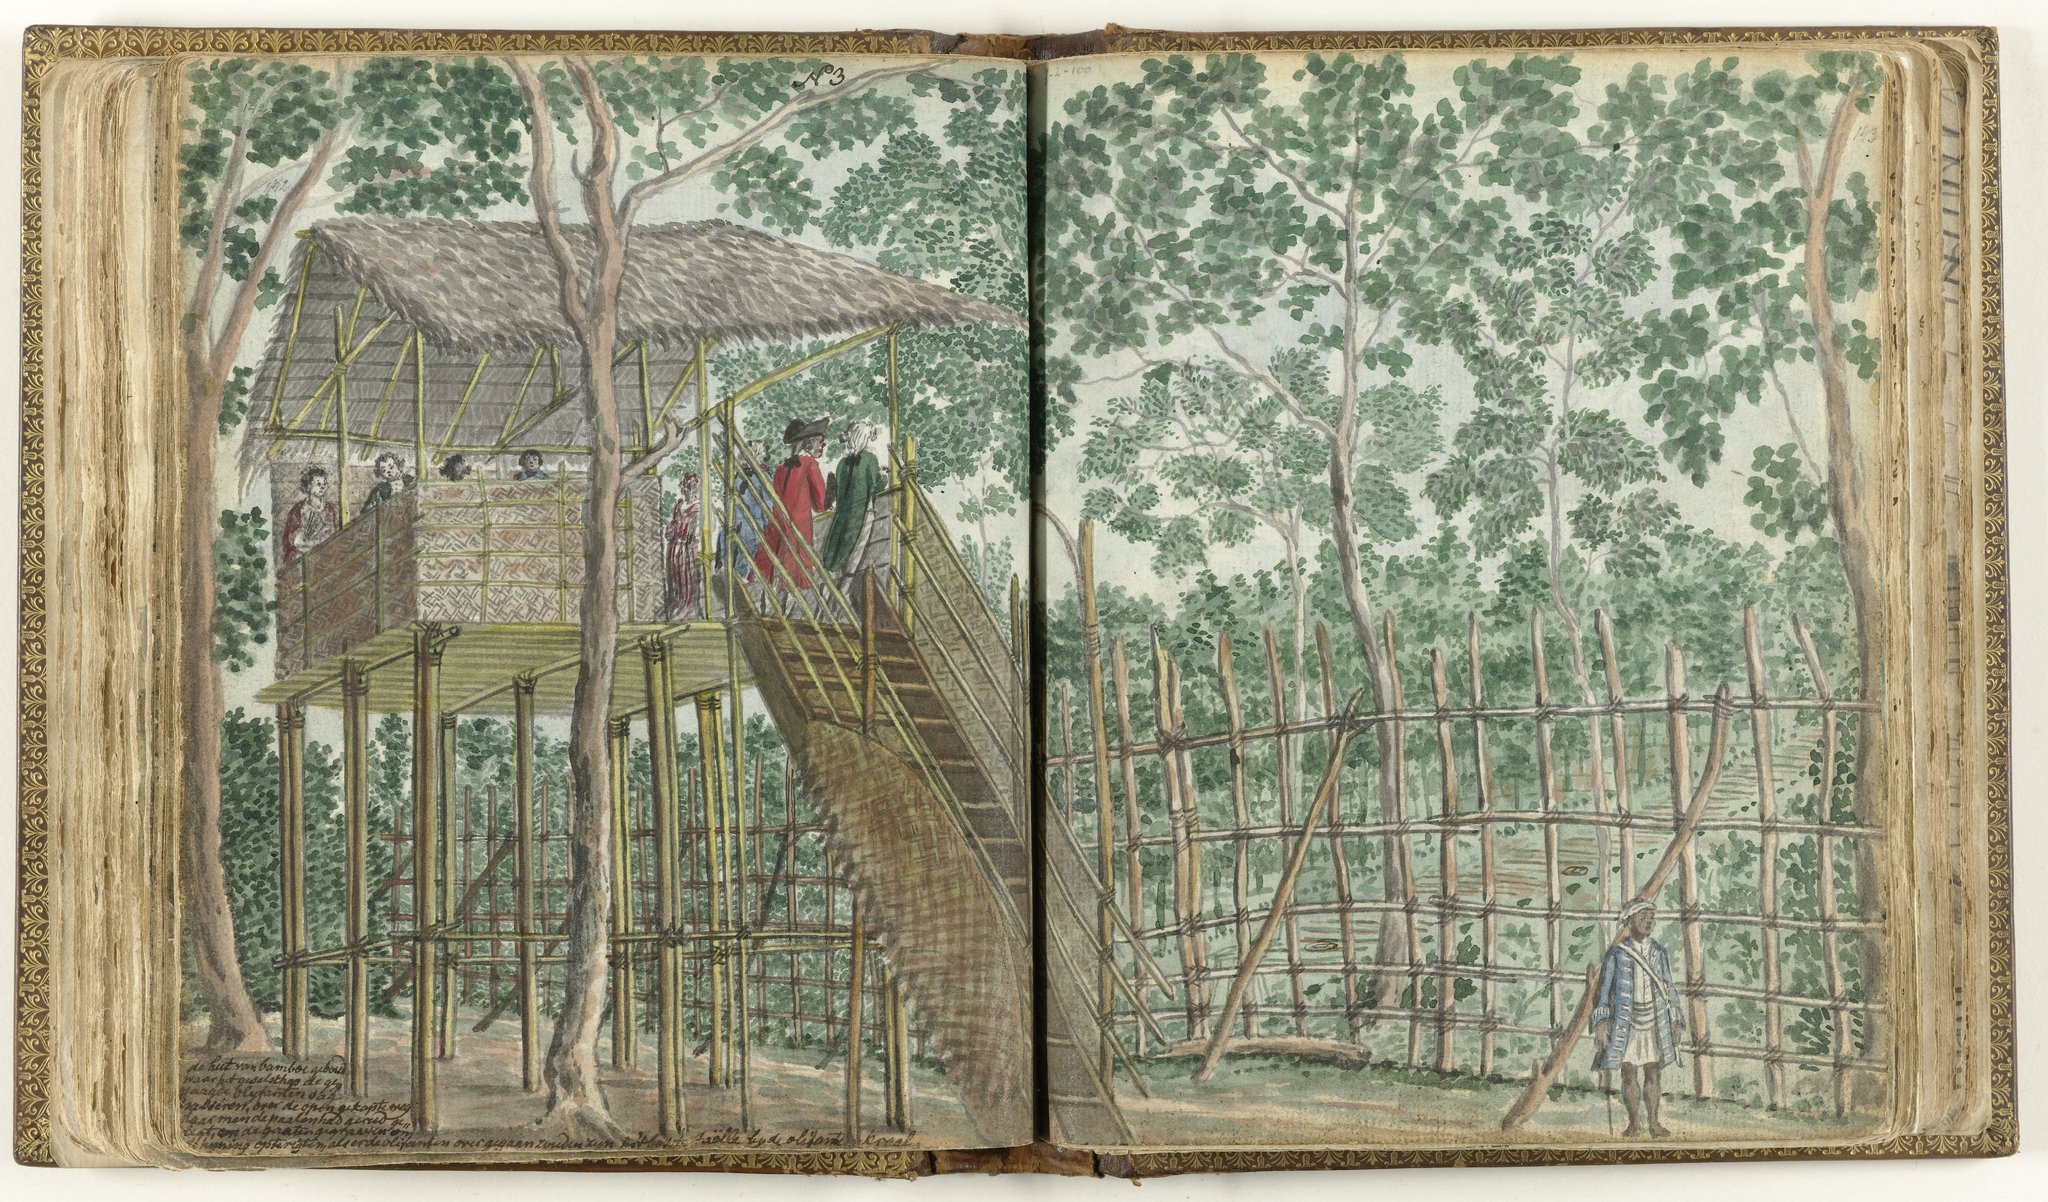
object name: drawing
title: Spectators at the Elephant Corral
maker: jan brandes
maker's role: draughtsman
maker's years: 1743-1808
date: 1712-1785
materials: paper, pencil, watercolor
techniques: brush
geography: ja-ela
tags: trunked animals: elephant, sri lanka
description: Kleurtekening over twee pagina's van een bamboehut op palen aan de rand van de losse kraal waarin de olifanten worden gedreven. In de hut staan een aantal heren met steek, pruik en pandjas en dames. Rechts staat een Singalese VOC-dienaar. Met opschrift. Nr. 3 in de serie Onderdeel uit het schetsboek van Jan Brandes, dl. 2 (1808), p. 142-143 (Voor situering zie nr. 1 van serie, p. 144.)